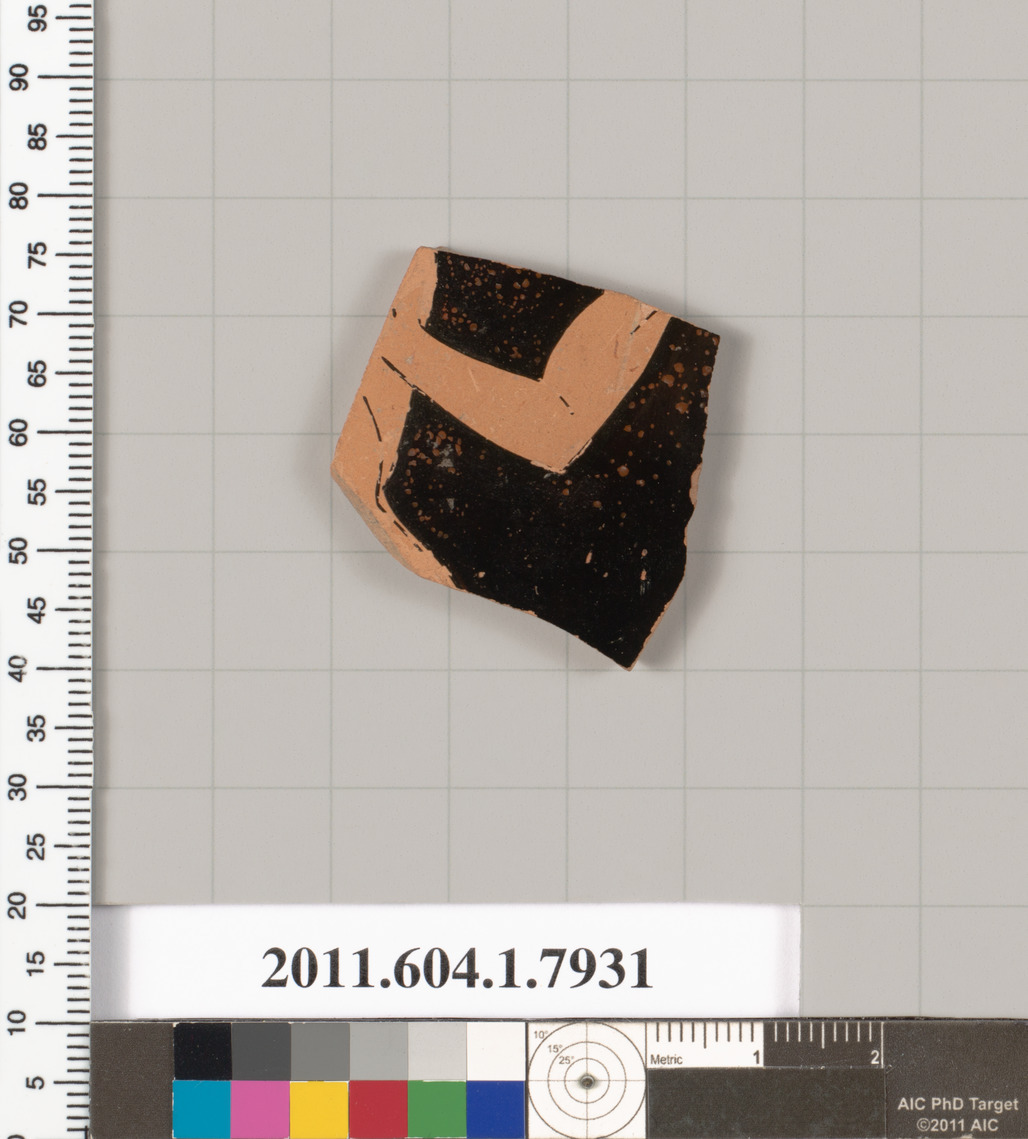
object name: kylix fragment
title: Terracotta fragment of a kylix (drinking cup)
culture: greek, attic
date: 460-450 BCE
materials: terracotta